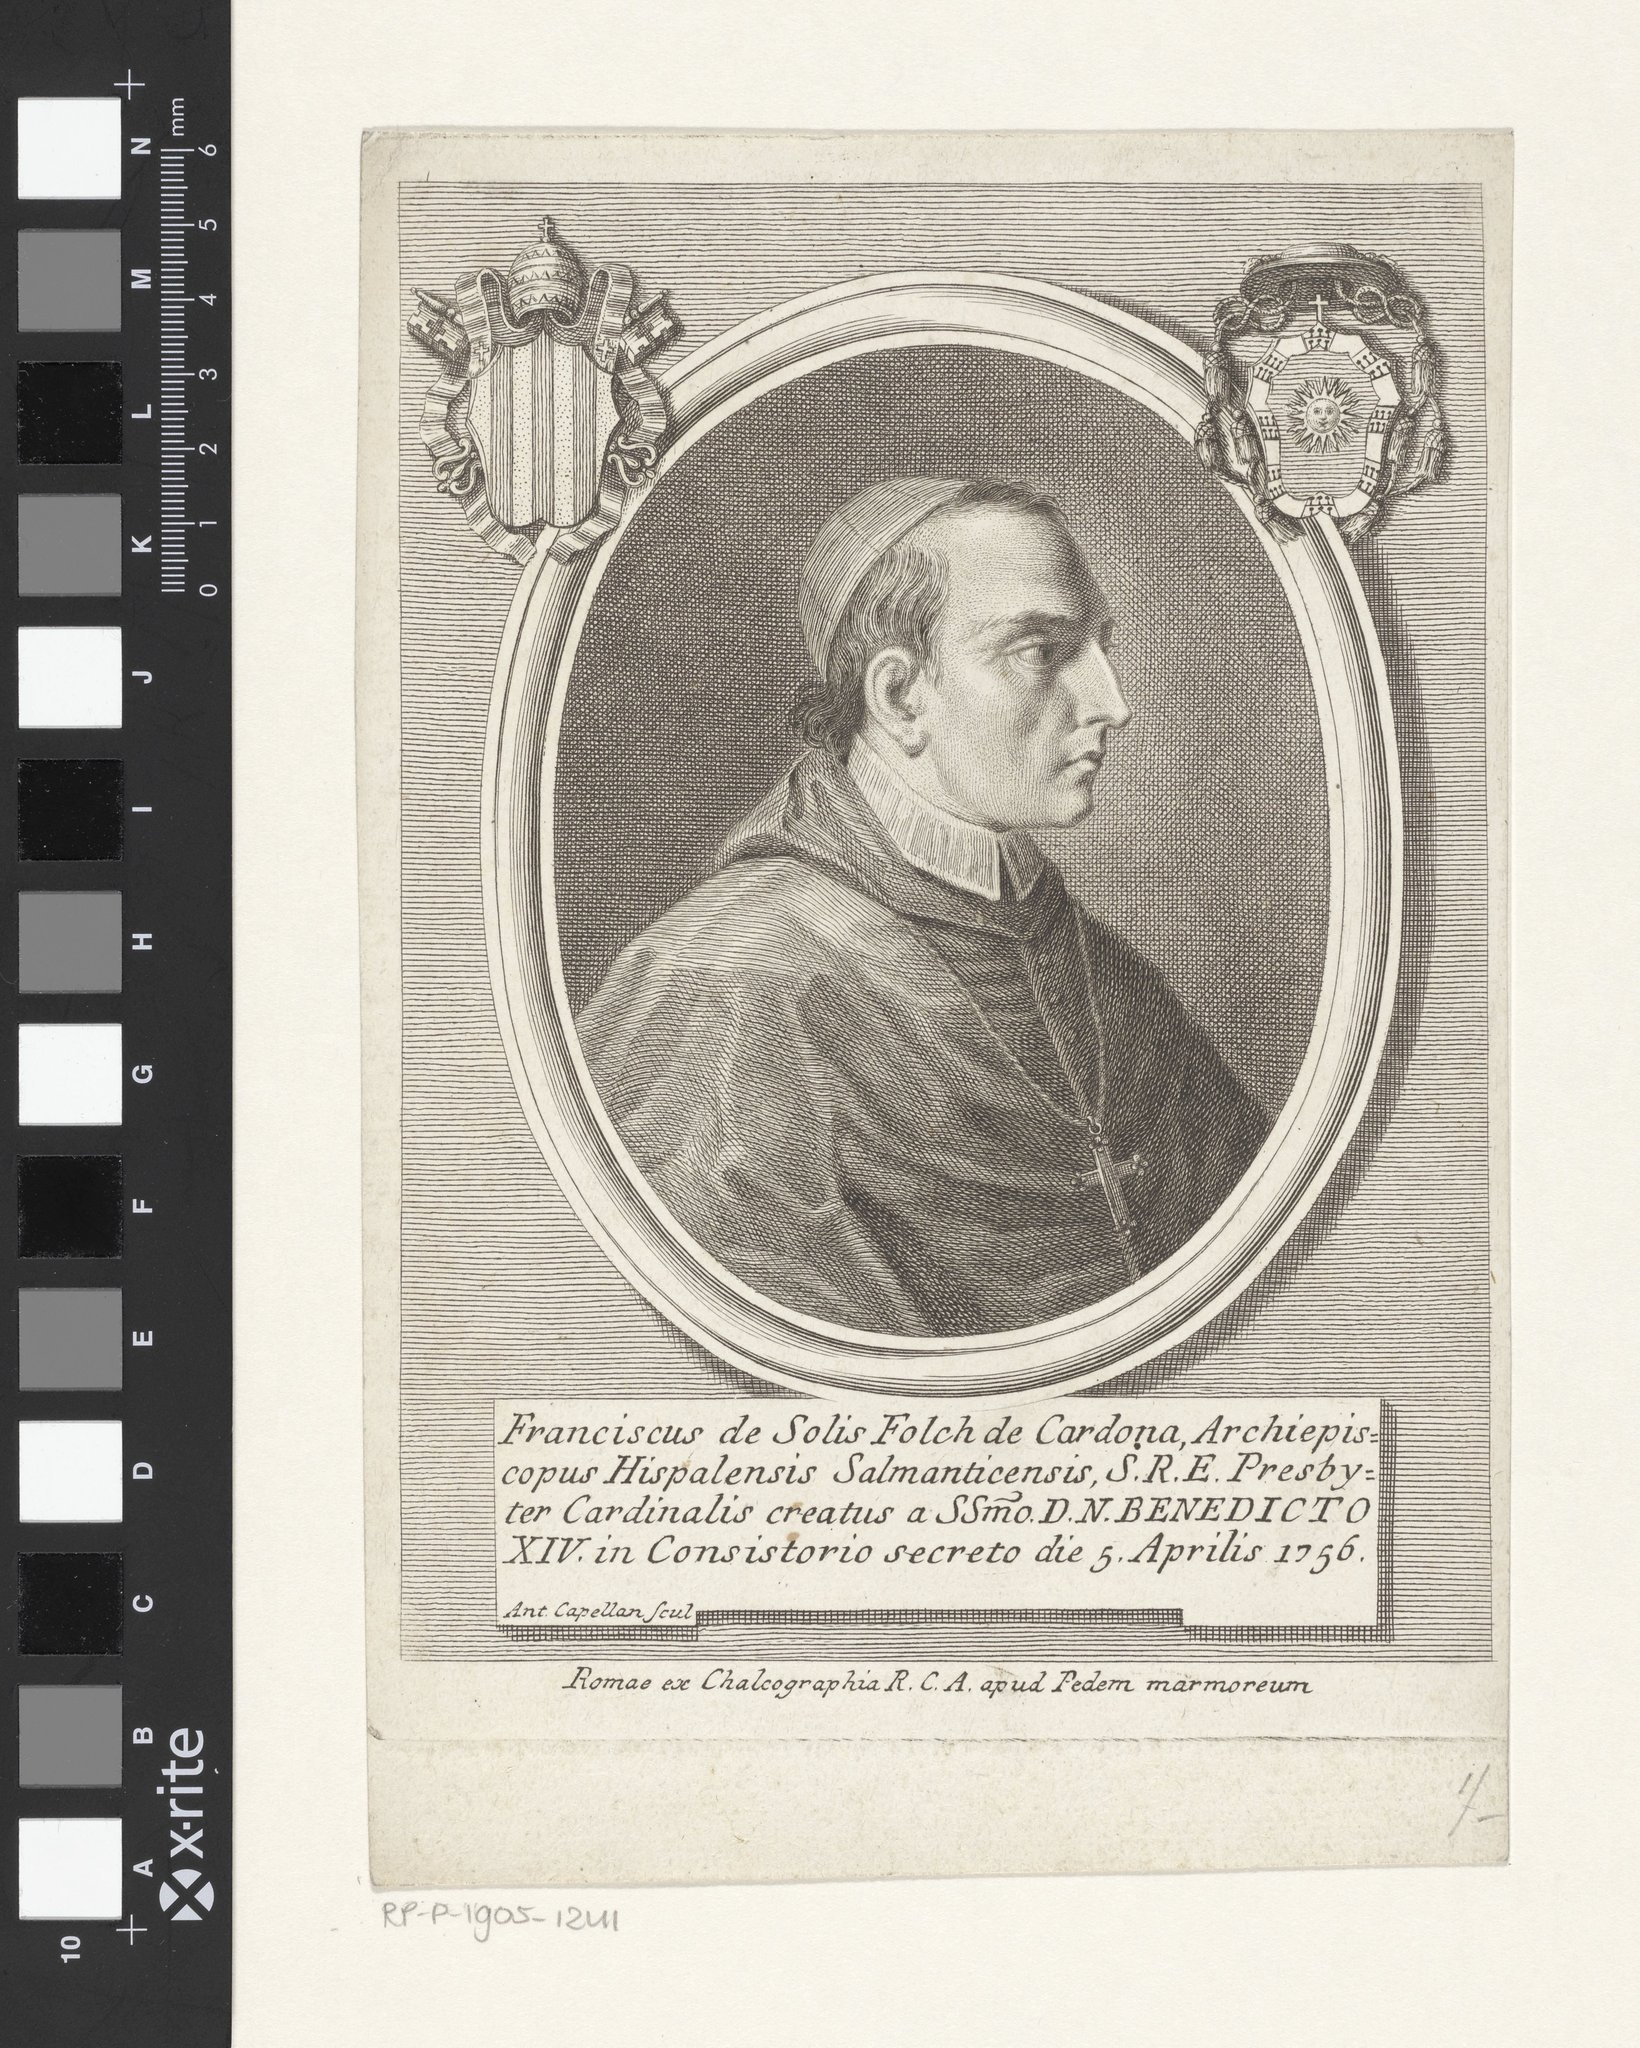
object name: print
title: Portretten van kardinalen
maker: antonio capellan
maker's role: print maker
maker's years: 1735-1788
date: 1756-1788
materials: paper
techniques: etching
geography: rome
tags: rome, cardinal, historical persons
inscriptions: collector's mark: Lugt 2228